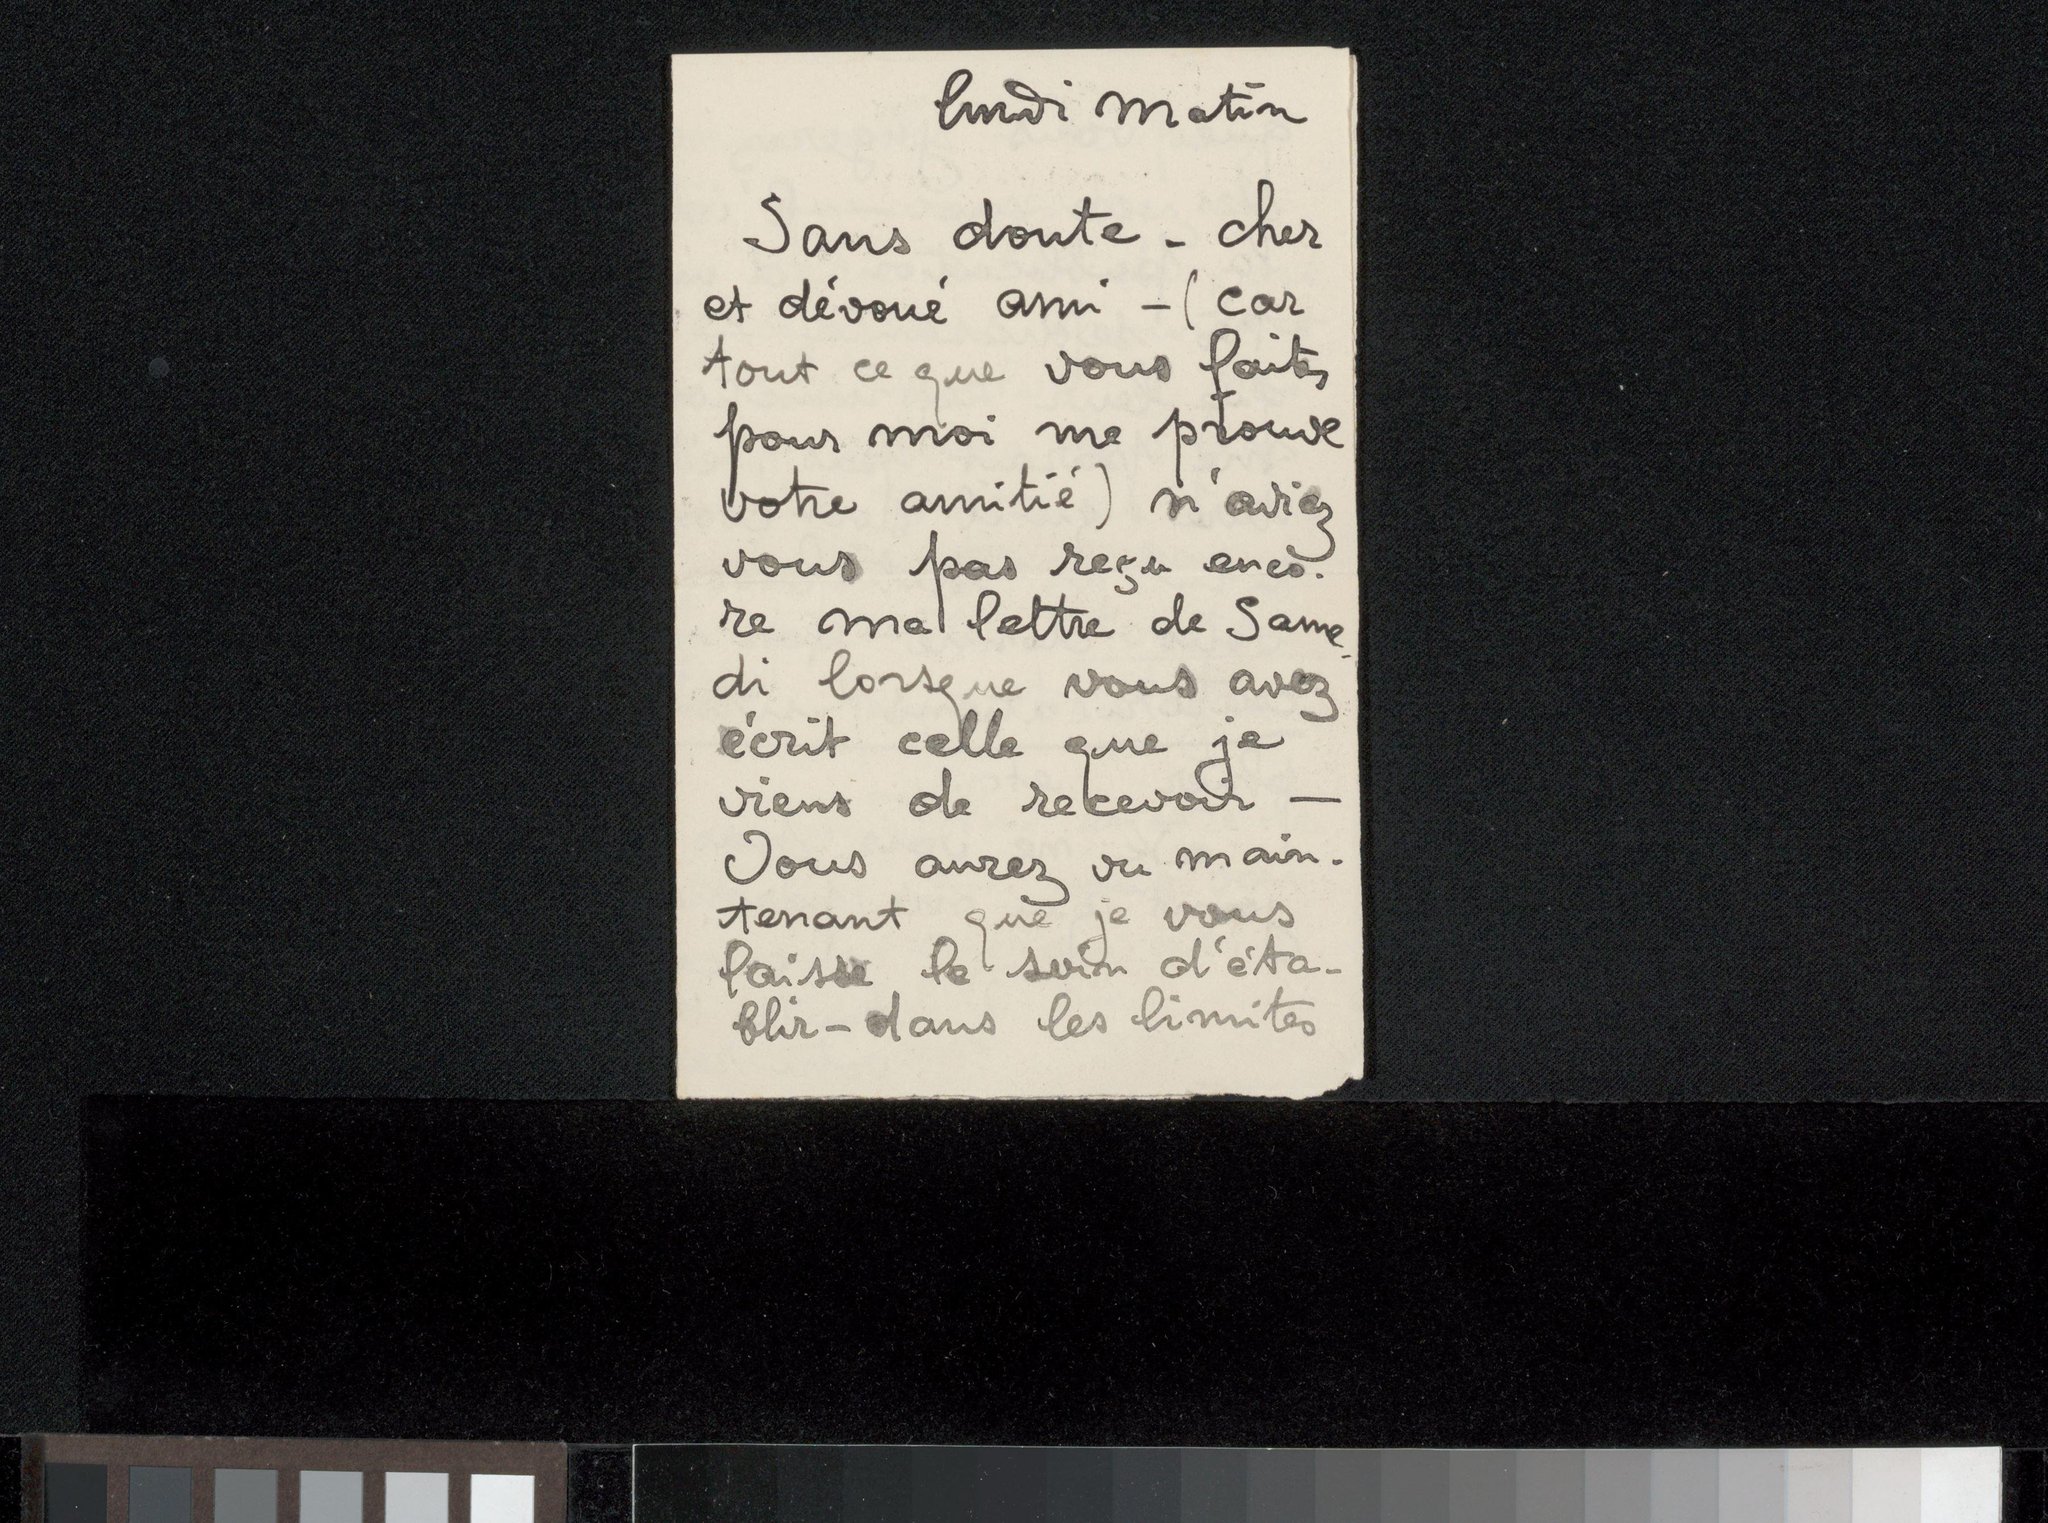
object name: letter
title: Brief aan Philip Zilcken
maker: théophile alexandre steinlen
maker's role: draughtsman, painter, print maker, sculptor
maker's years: 1859-1923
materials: ink, paper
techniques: pen, writing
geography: paris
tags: the hague, painter, philip zilcken, drawing, photography, cinematography, printed matter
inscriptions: collector's mark: ‘RPK’